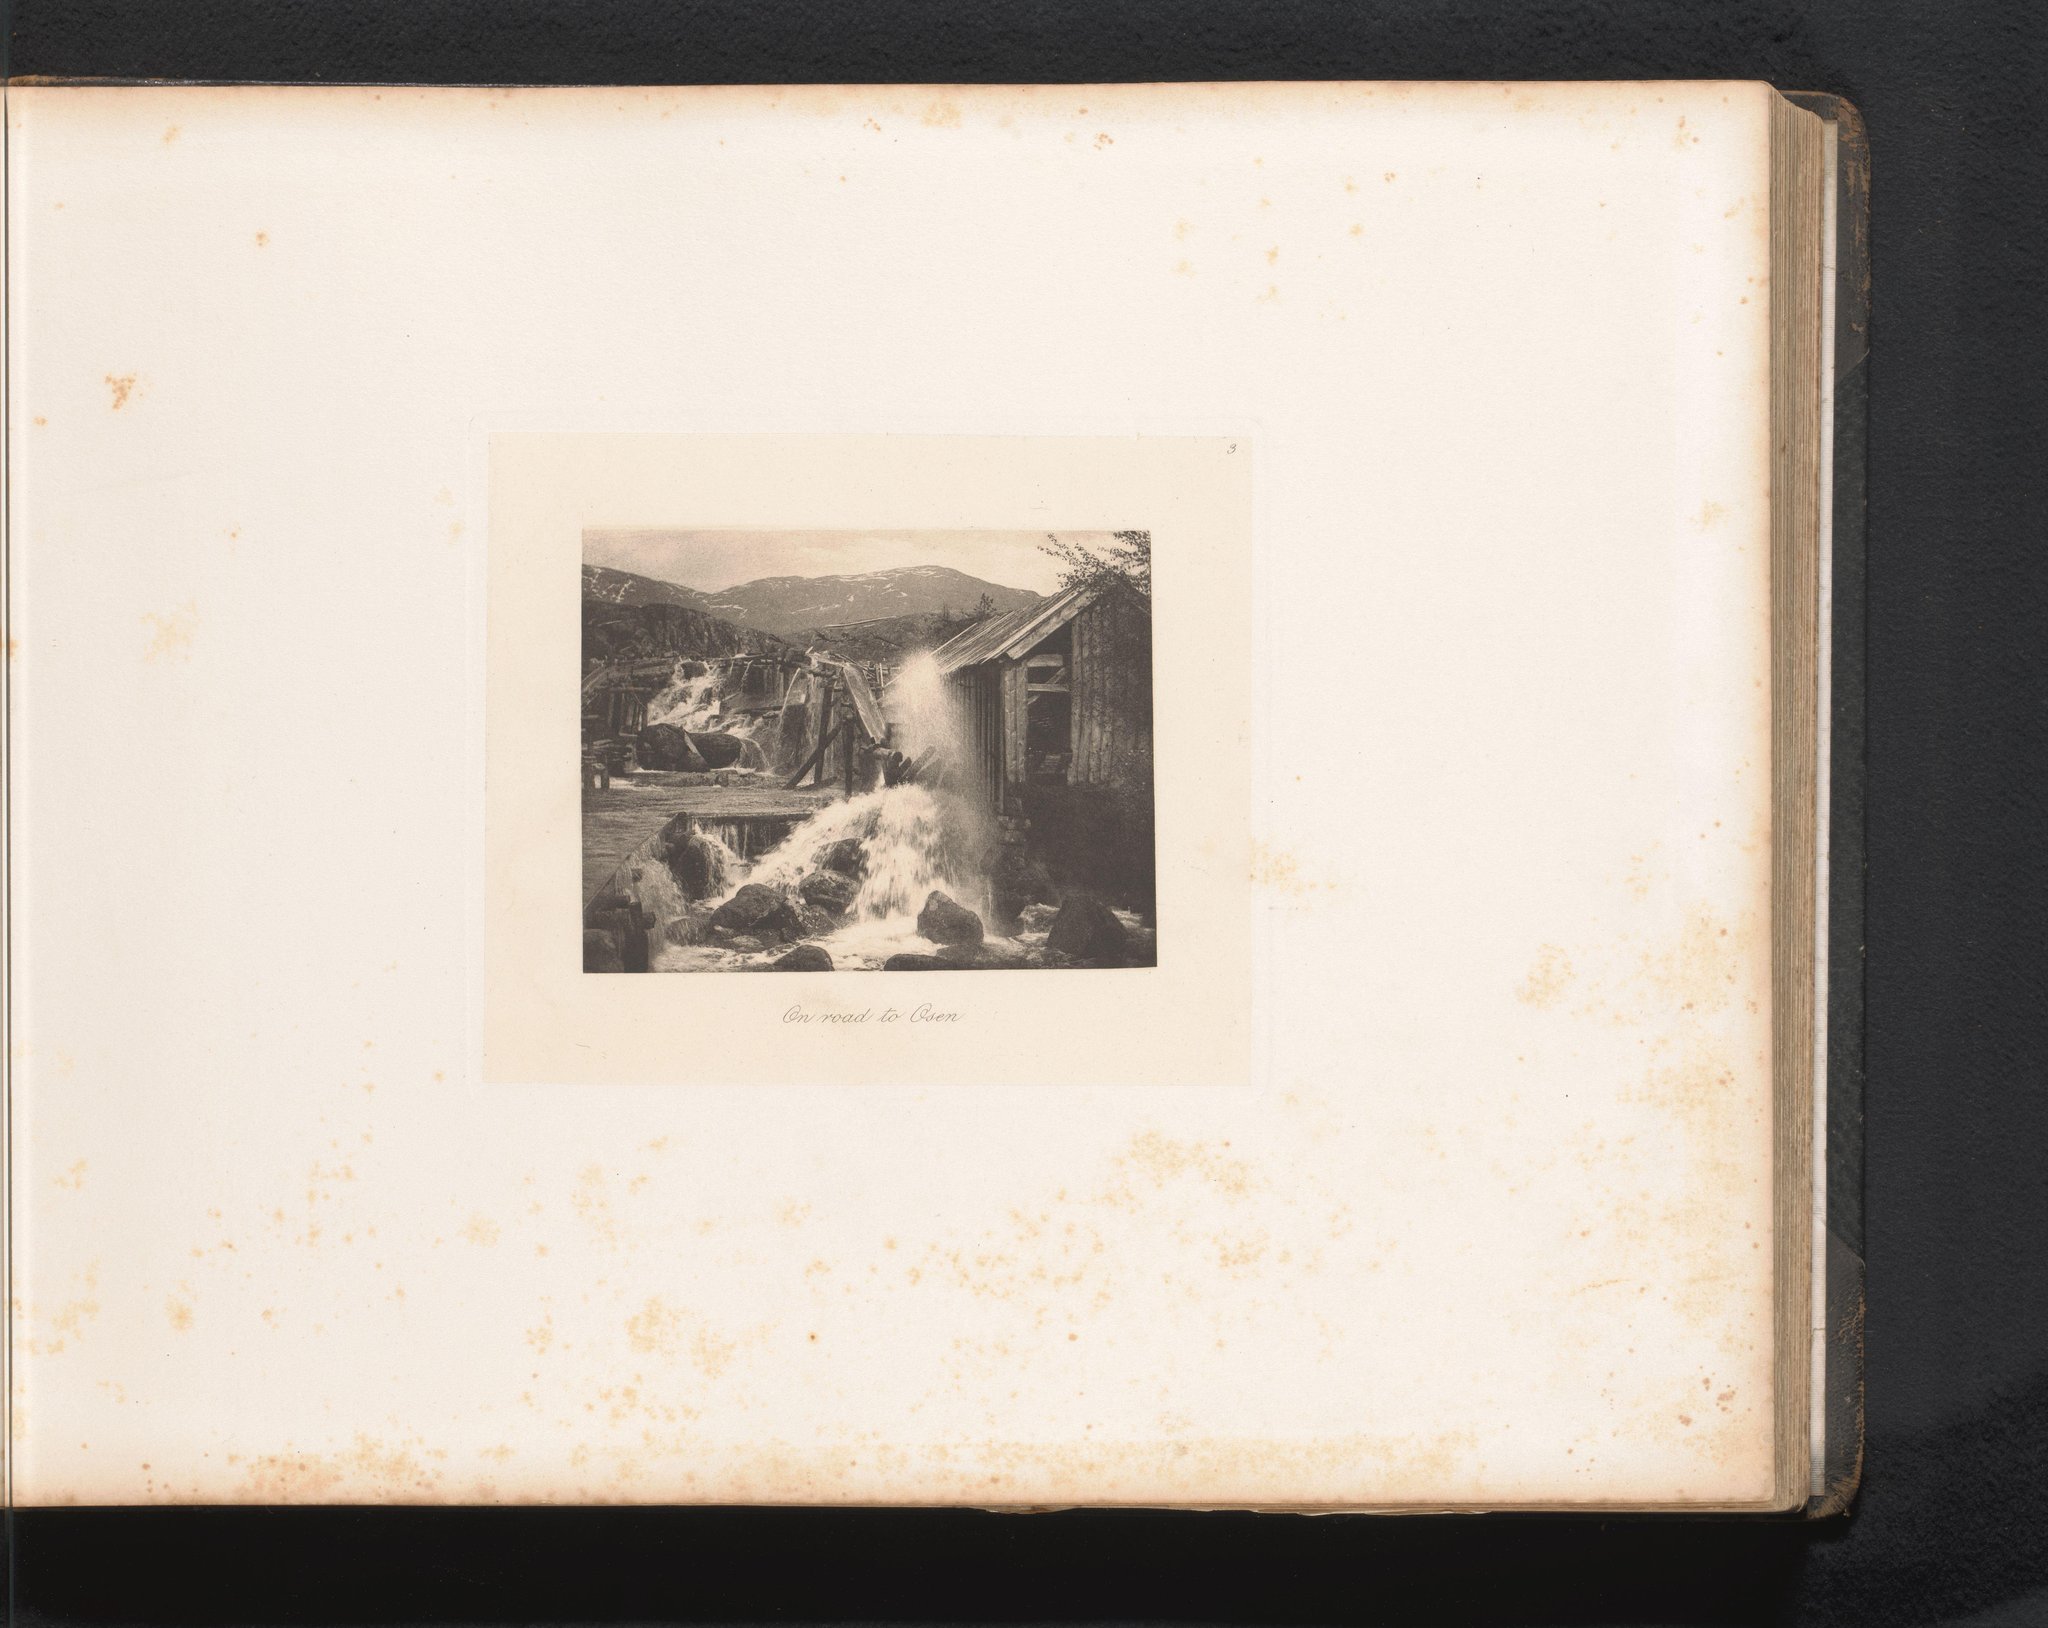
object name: photomechanical print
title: Berglandschap met zaagmolen nabij Suldalsosen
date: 1888-1893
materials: paper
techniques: photograph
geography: vienna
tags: saw-mill (works), waterfall, mountains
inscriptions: number: ‘3’